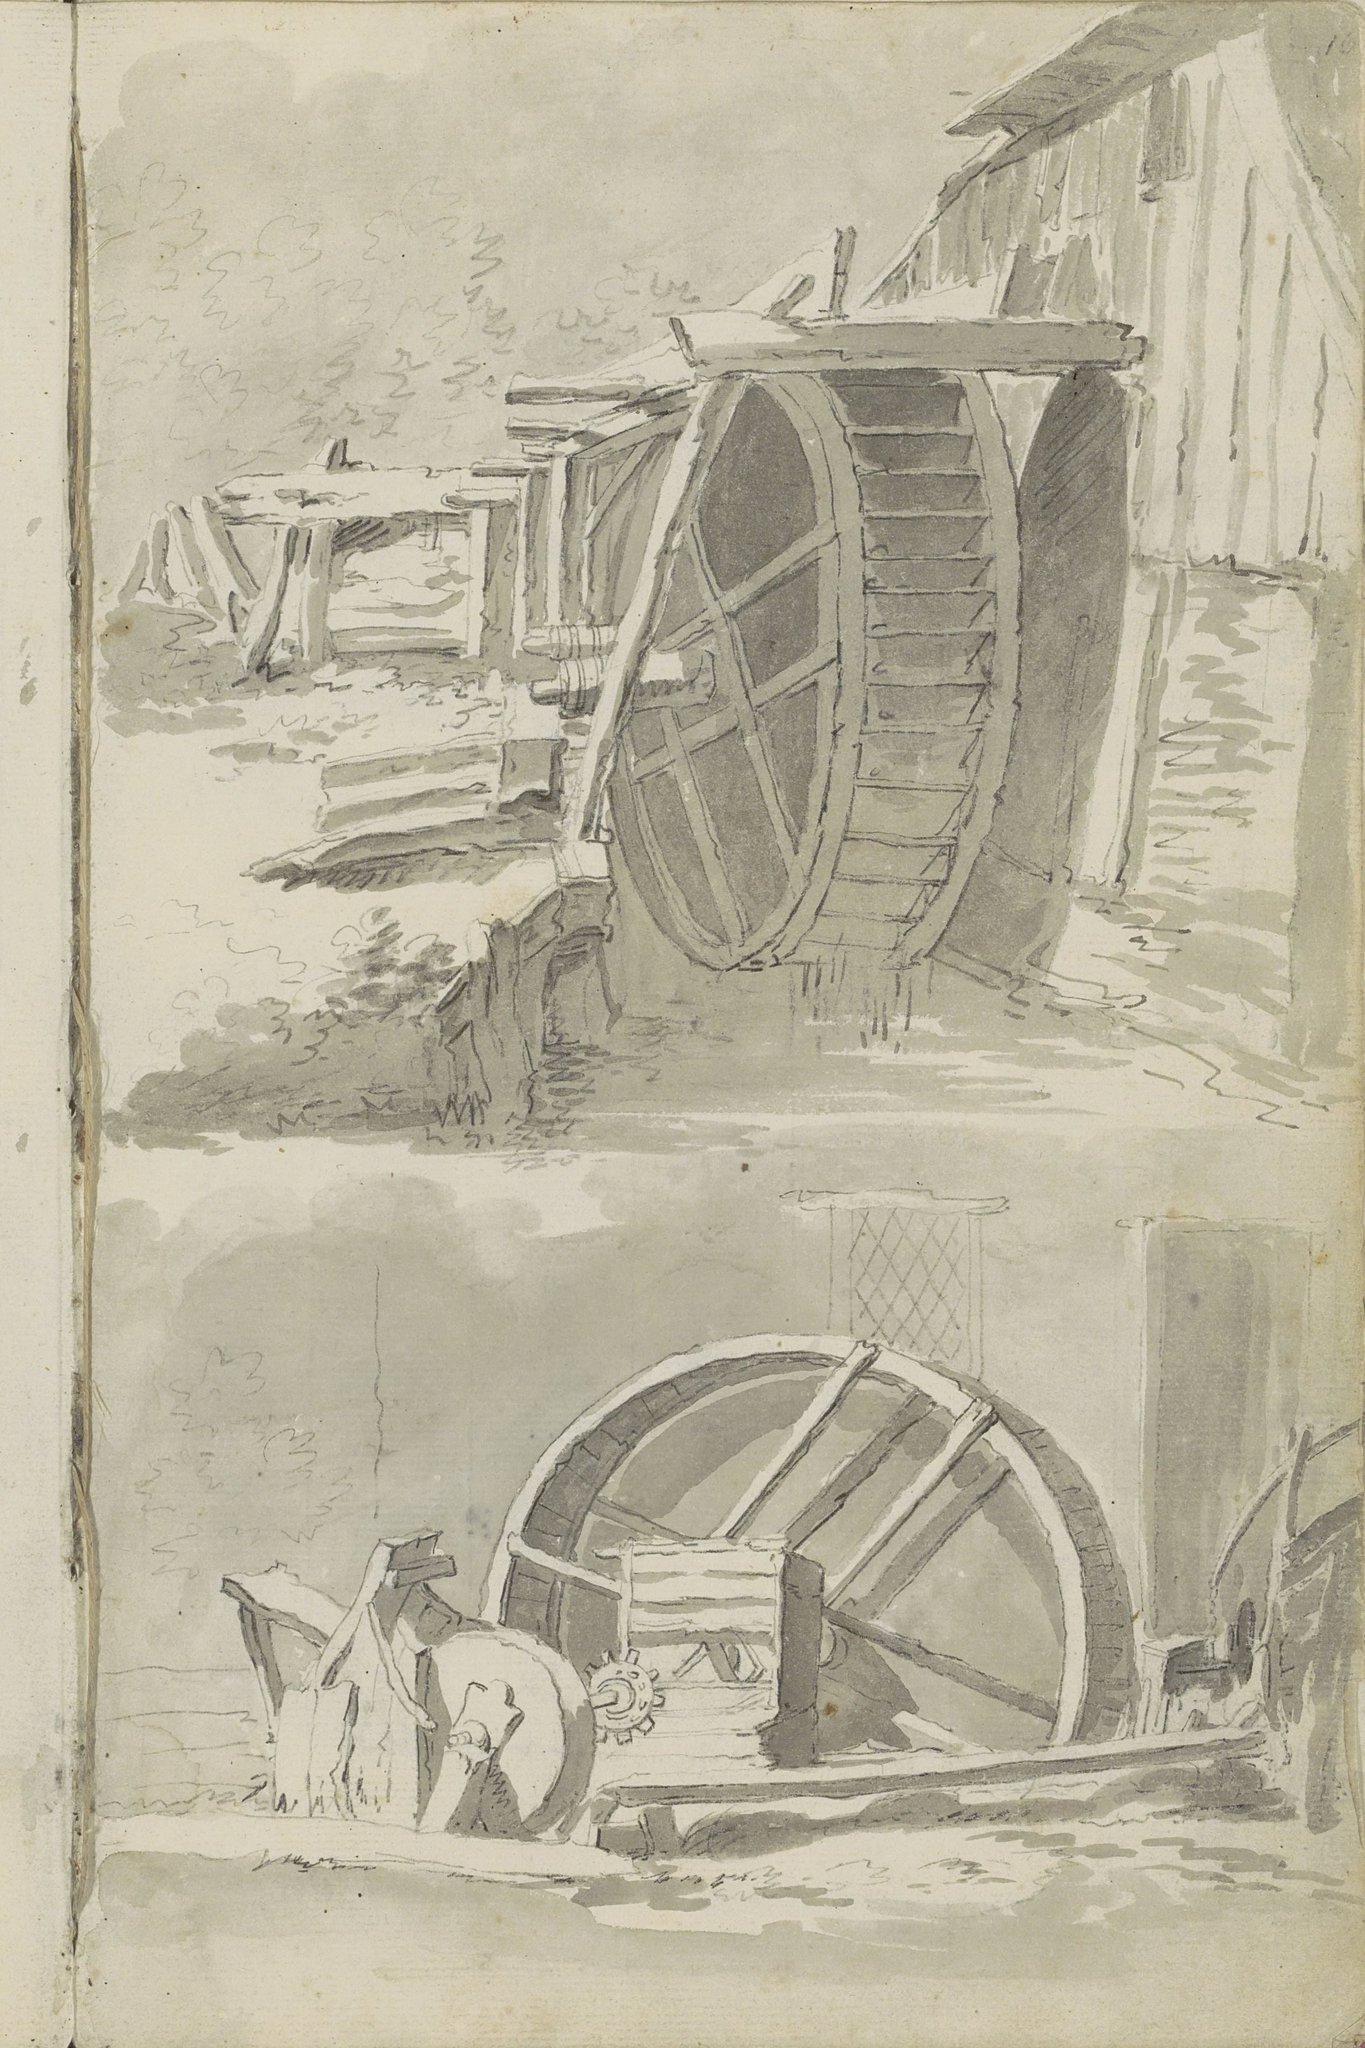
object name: sketchbook leaf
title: Waterraden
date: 1780-1800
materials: paper, pencil, watercolor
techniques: brush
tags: watermill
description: Blad 4 recto uit een schetsboek met 25 bladen.